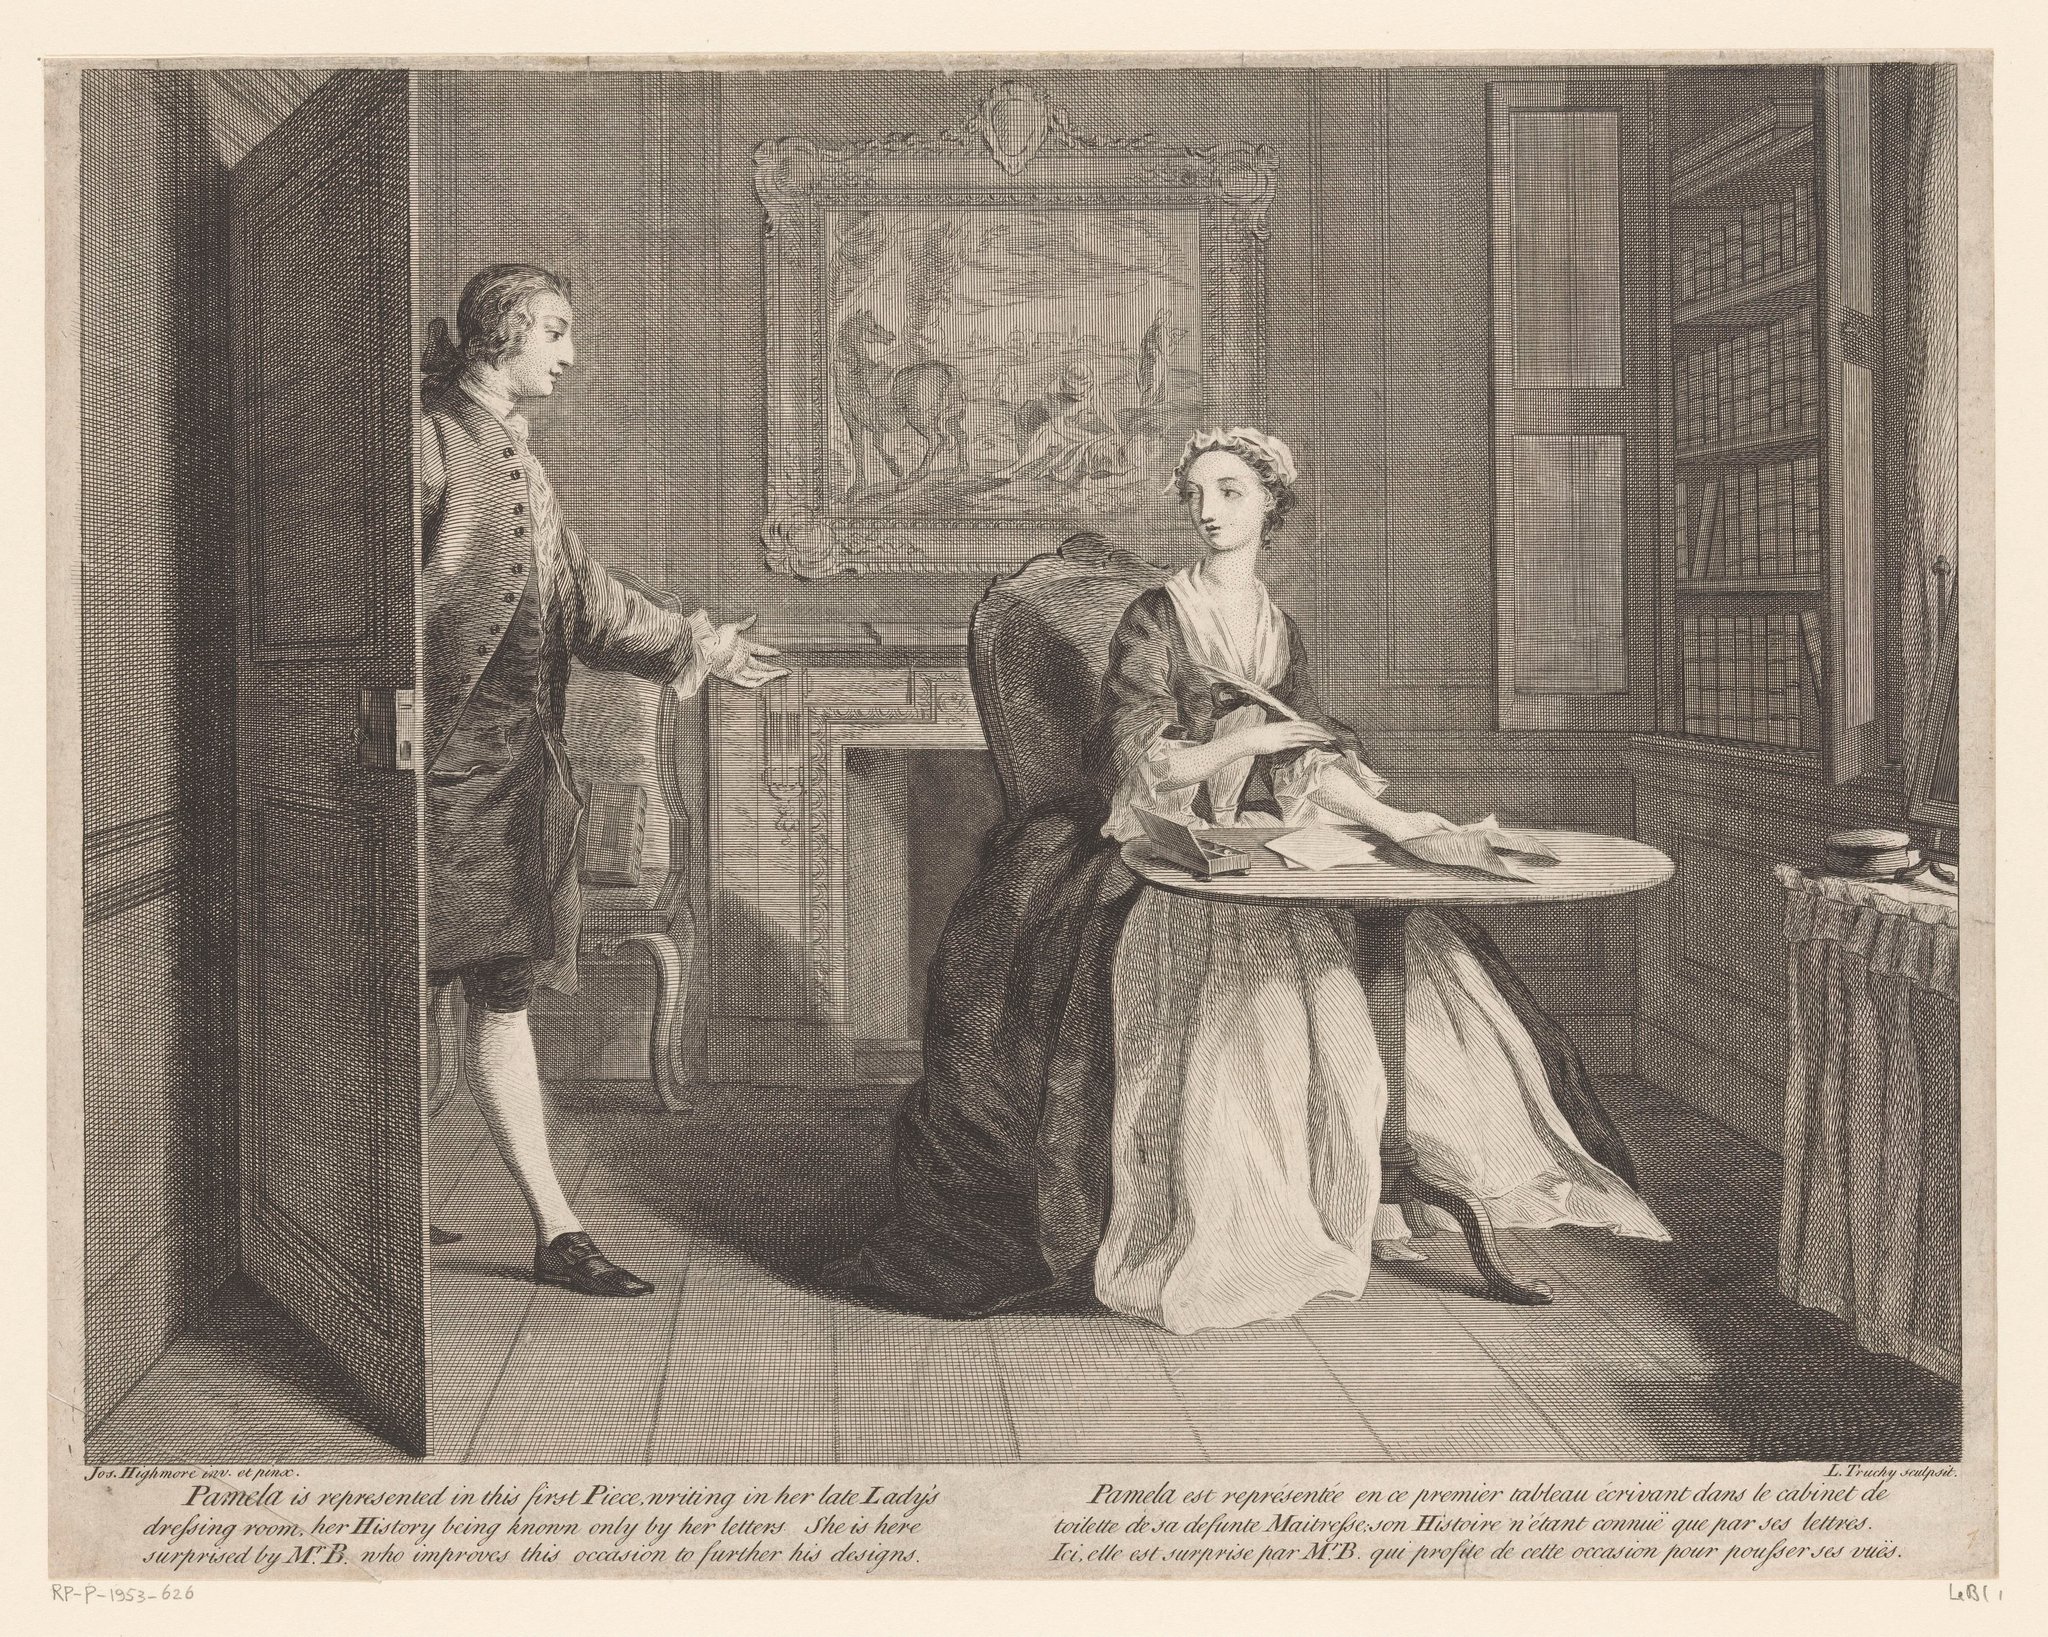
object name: print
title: Pamela schrijvend in de kleedkamer van haar meesteres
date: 1745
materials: paper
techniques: engraving, etching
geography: england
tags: handwriting, writing as activity, the good samaritan (luke 10:30-37), art (+ painting), defence of chastity, male literary characters (pamela)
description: Maakt deel uit van een serie van twaalf prenten naar schilderijen door Joseph Highmore uit 1744, gebaseerd op de Engelse zedenroman "Pamela, or; Virtue rewarded" geschreven door Samual Richardson en gepubliceerd in 1740-1741. Pamela is een jonge dienstbode die in haar brieven haar ouders op de hoogte houdt van haar avonturen. Als haar meesteres sterft komt ze onder de hoede van de zoon des huizes, graaf Belfart, die haar vergeefs probeert te verleiden. Uiteindelijk trouwt hij haar alsnog.